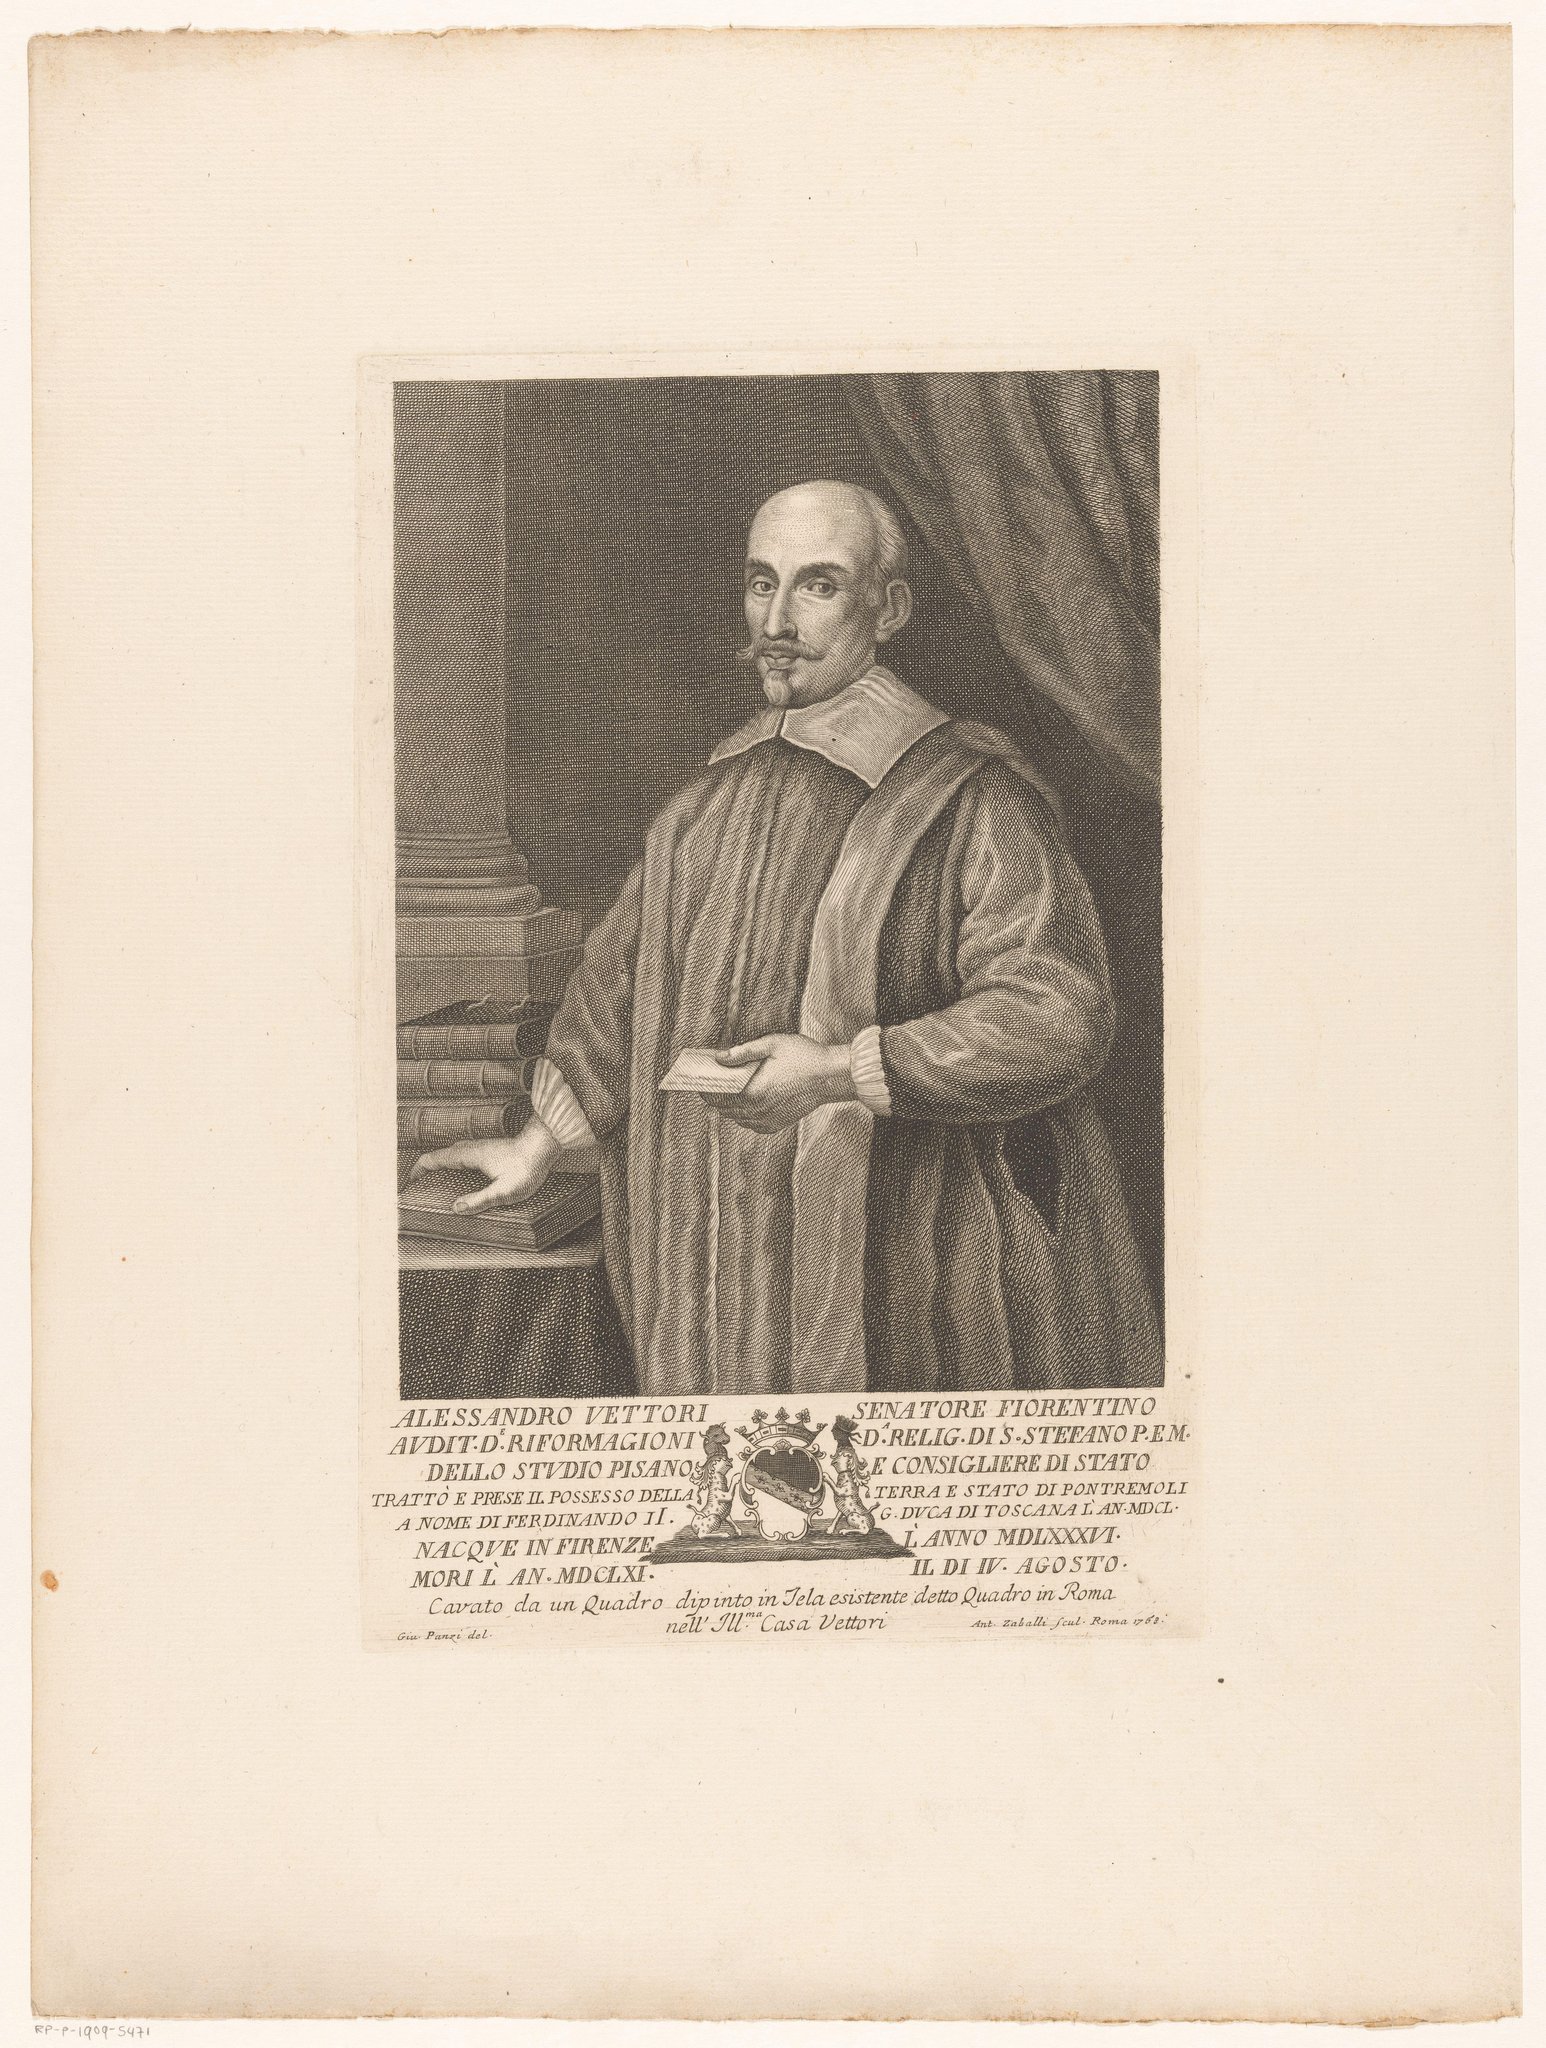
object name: print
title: Portret van senator Alessandro Vettori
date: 1768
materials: paper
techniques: engraving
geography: italy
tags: historical persons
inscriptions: collector's mark: Lugt 2228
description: Deze prent maakt deel uit van een serie van onbekende omvang met portretten van de familie Vettòri.